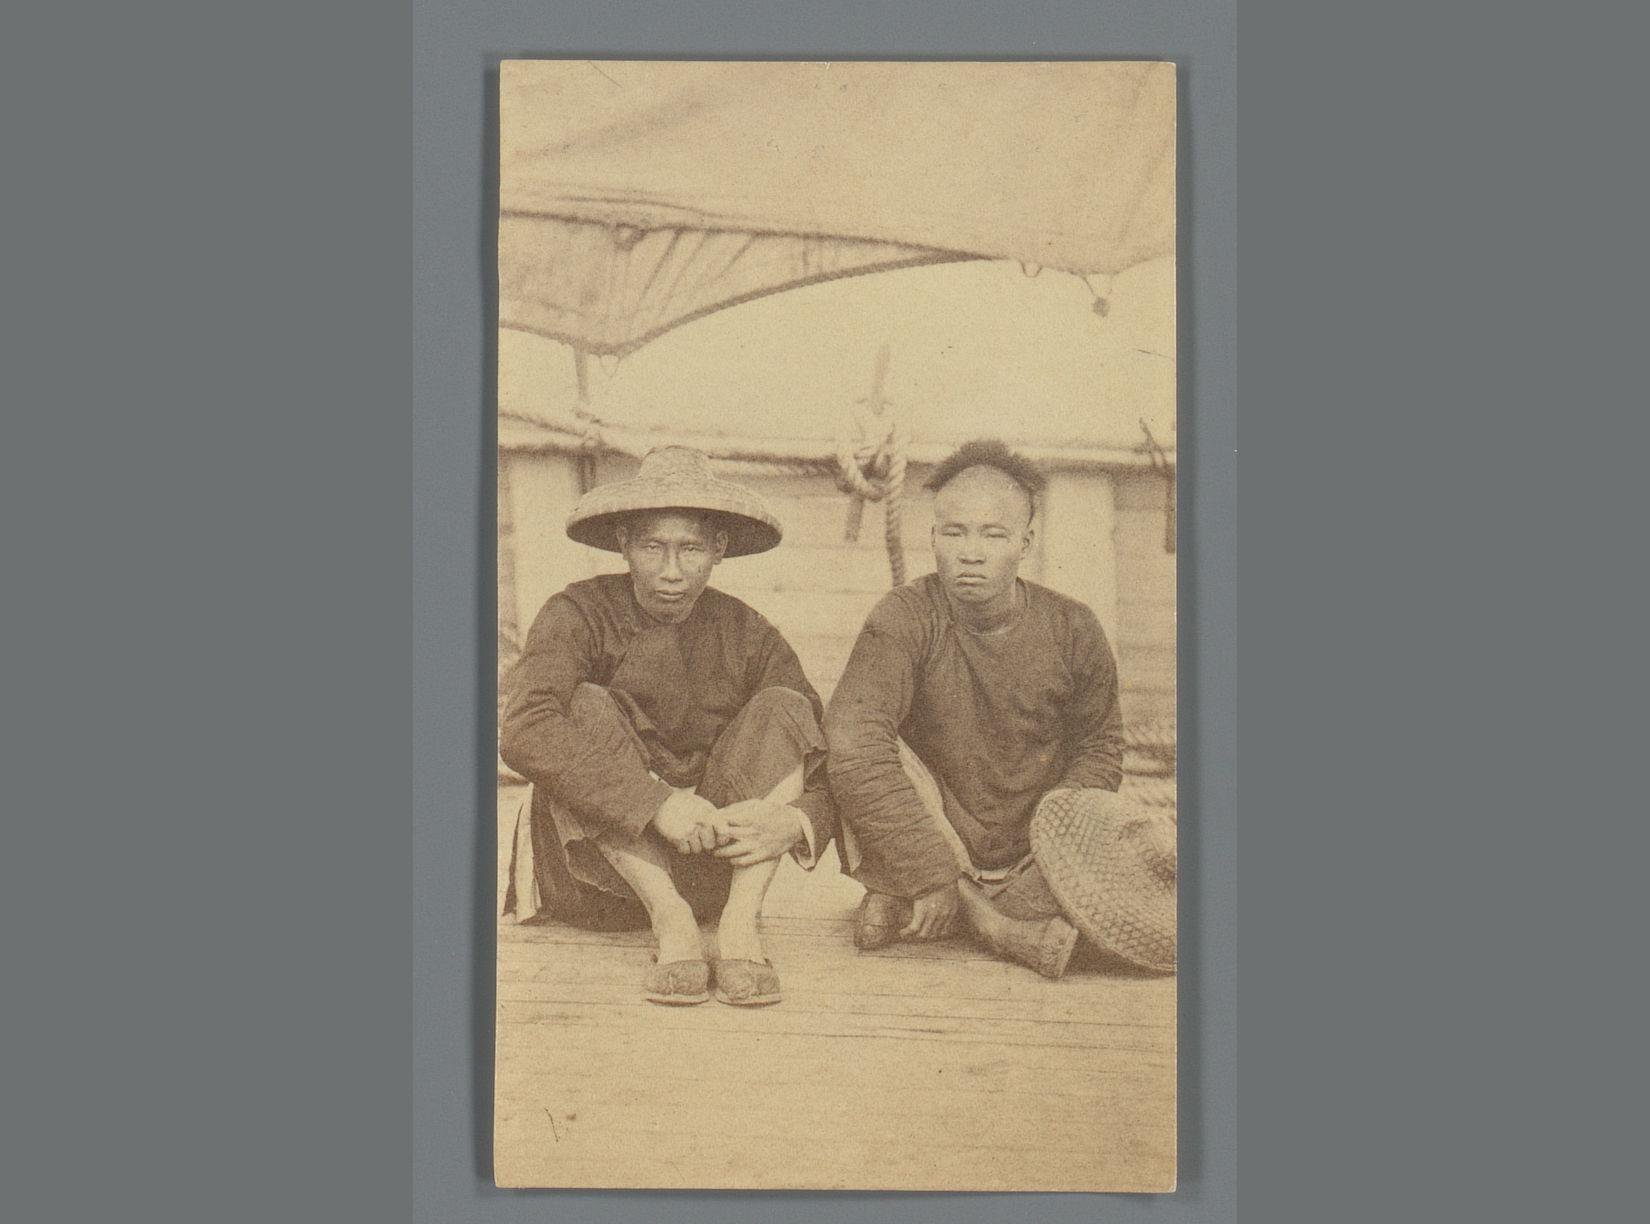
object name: photograph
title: Portret van twee onbekende Chinese mannen zittend op een schip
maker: Anonymous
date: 1860-1890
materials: paper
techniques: albumen print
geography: china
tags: historical persons not known by name, china